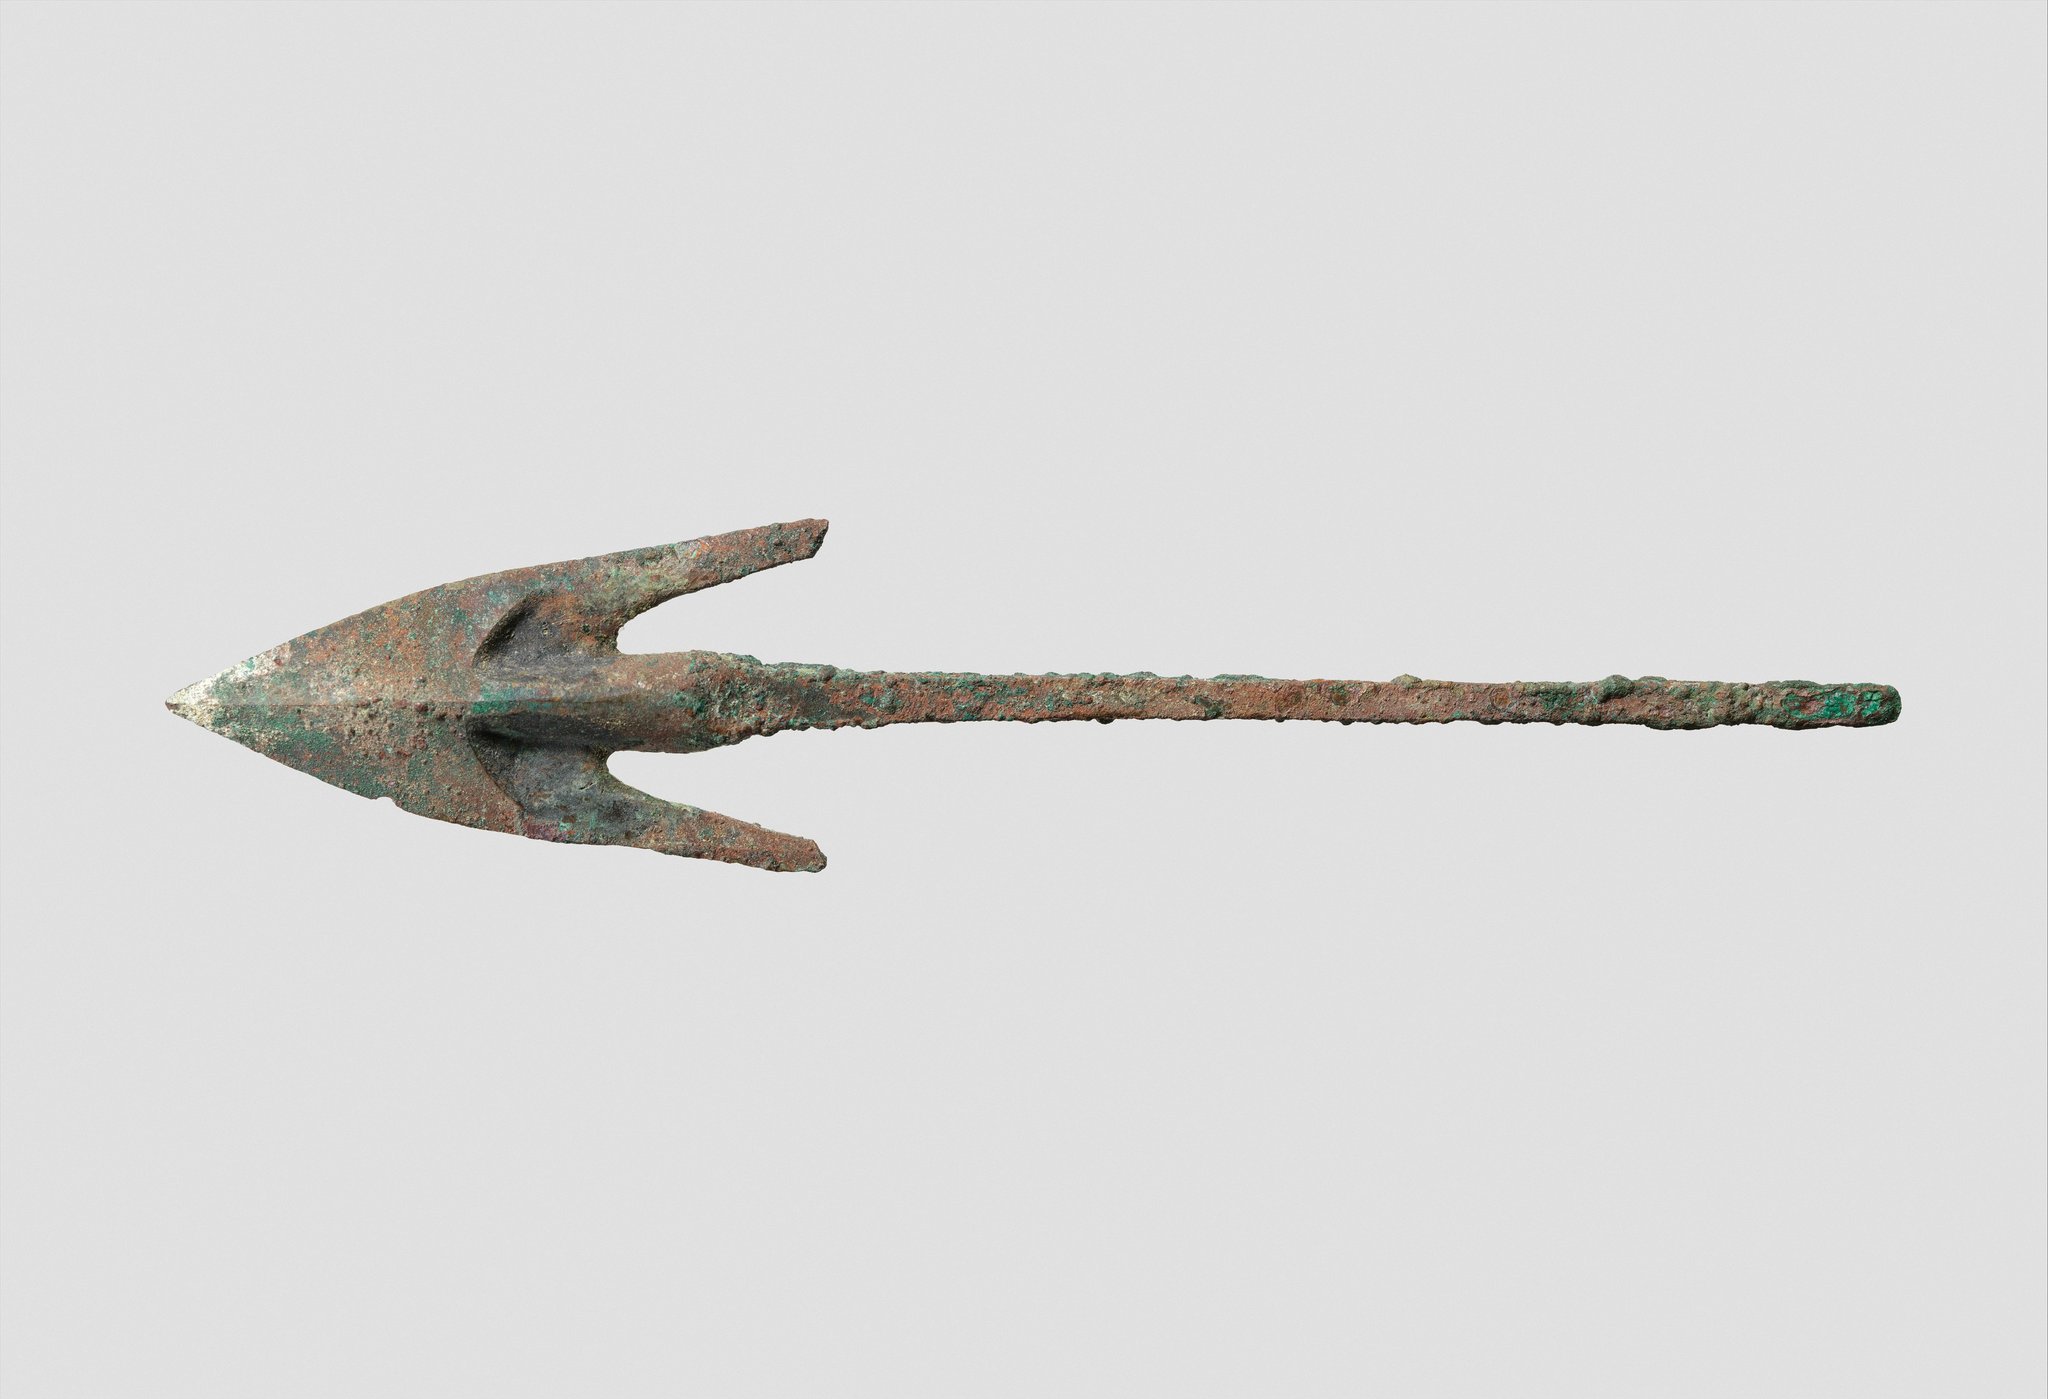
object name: arrowhead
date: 1000-668 BCE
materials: bronze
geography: transcaucasia